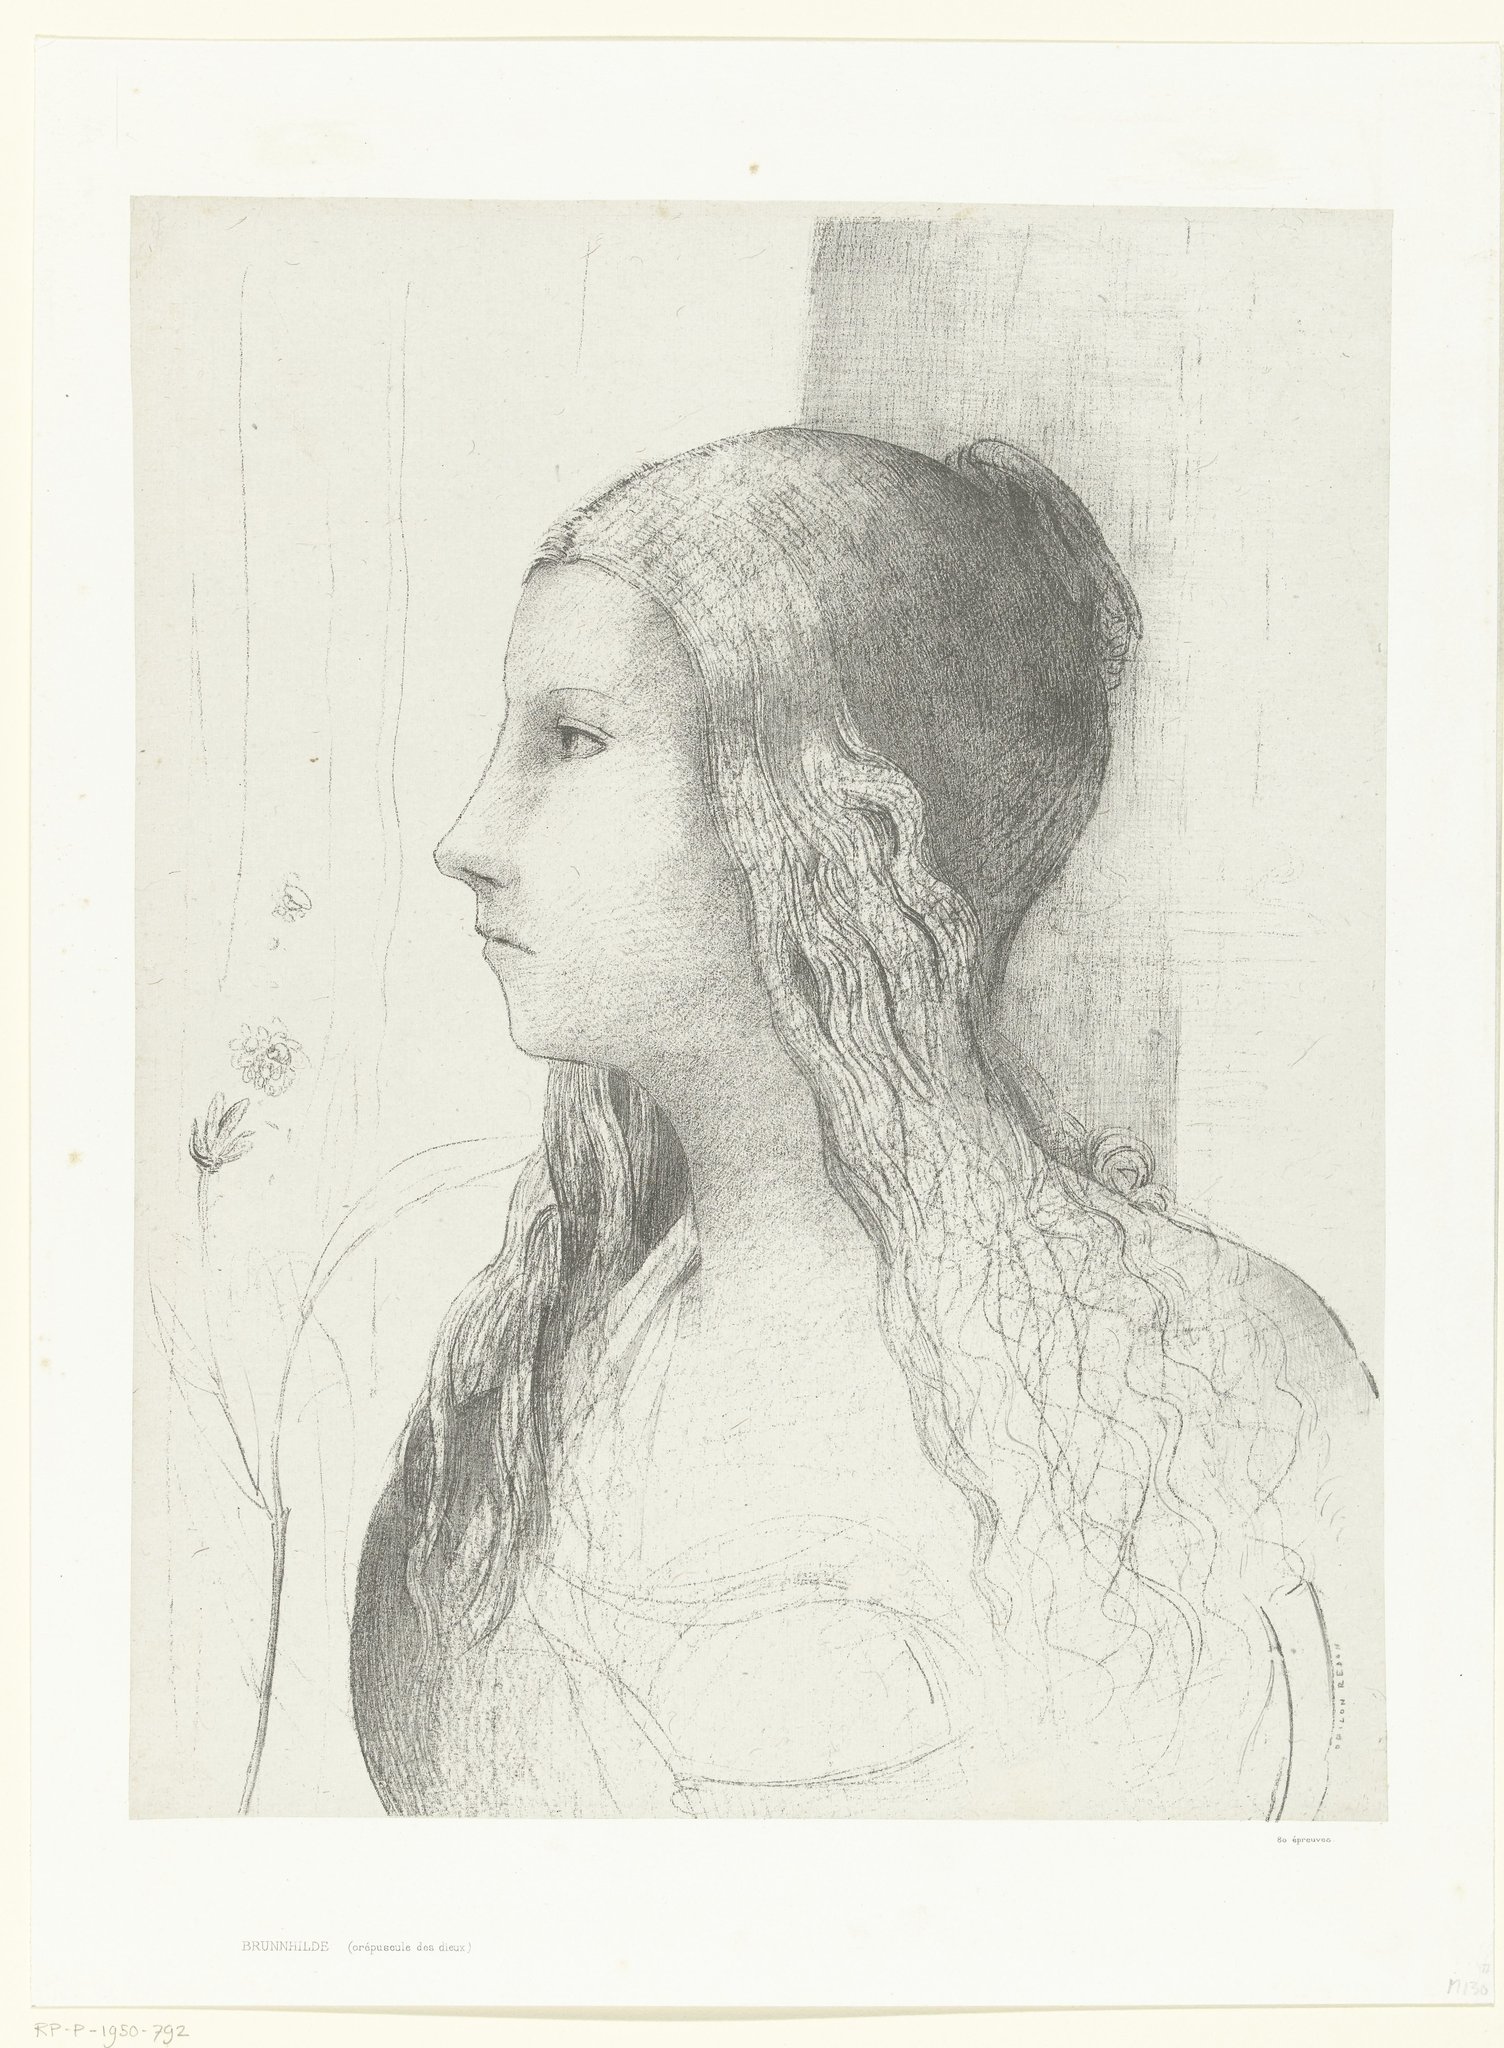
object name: print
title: Brunhilde (ondergang van de Goden)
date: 1894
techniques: printmaking, lithograph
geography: france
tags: brunhild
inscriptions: collector's mark: Lugt 789a, collector's mark: Lugt 2228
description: Brunhilde, een vrouw uit de Noorse mythologie, en profil.